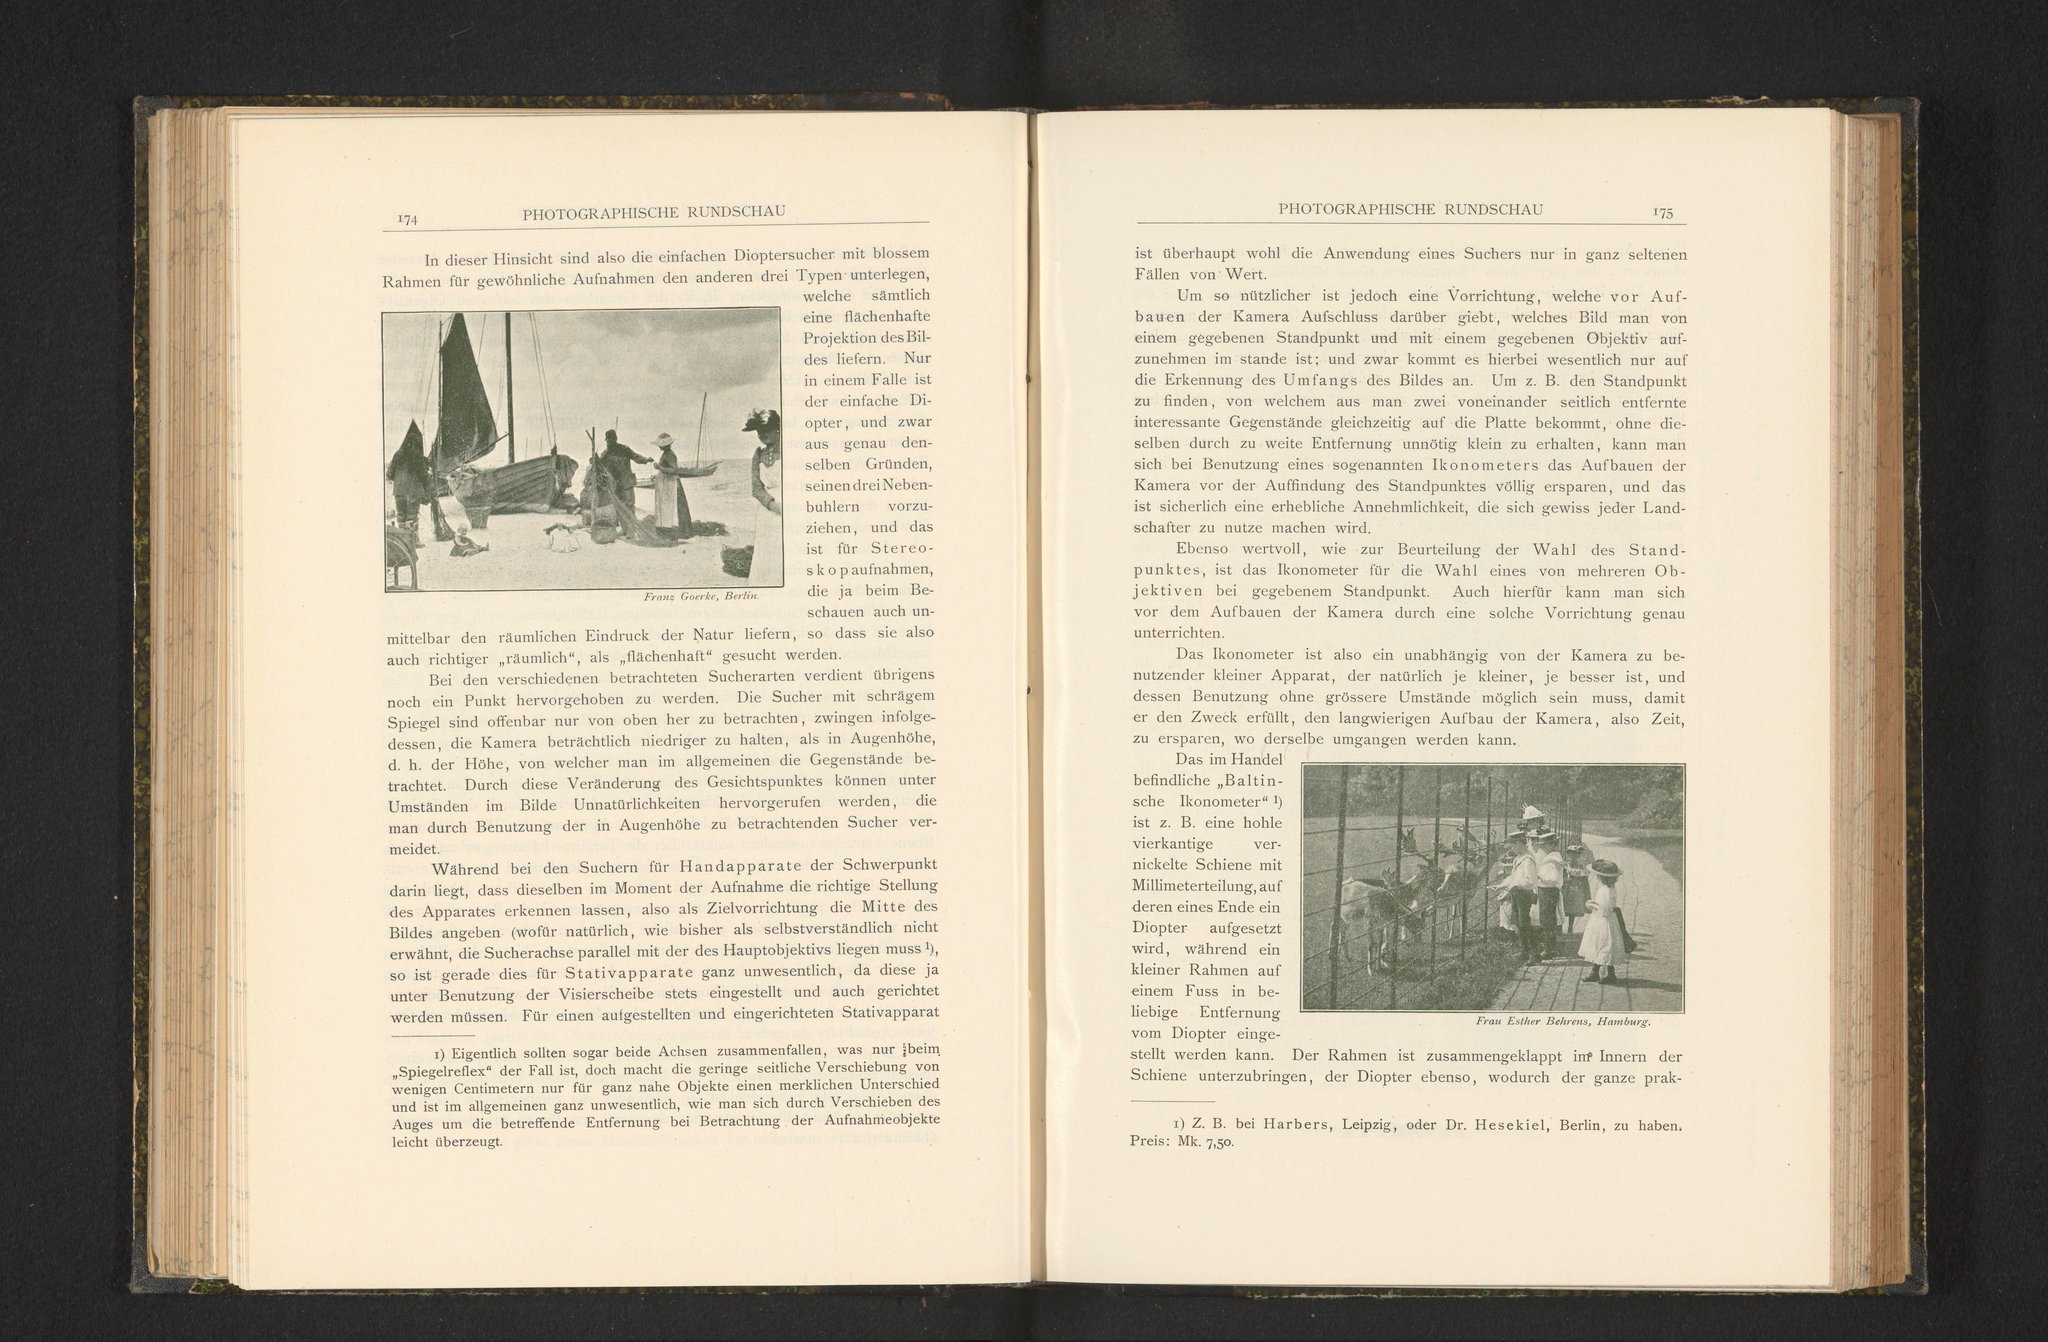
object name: page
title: Kinderen voeren herten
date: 1893-1898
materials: paper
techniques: autotype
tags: hoofed animals: deer, child, feeding wild animals